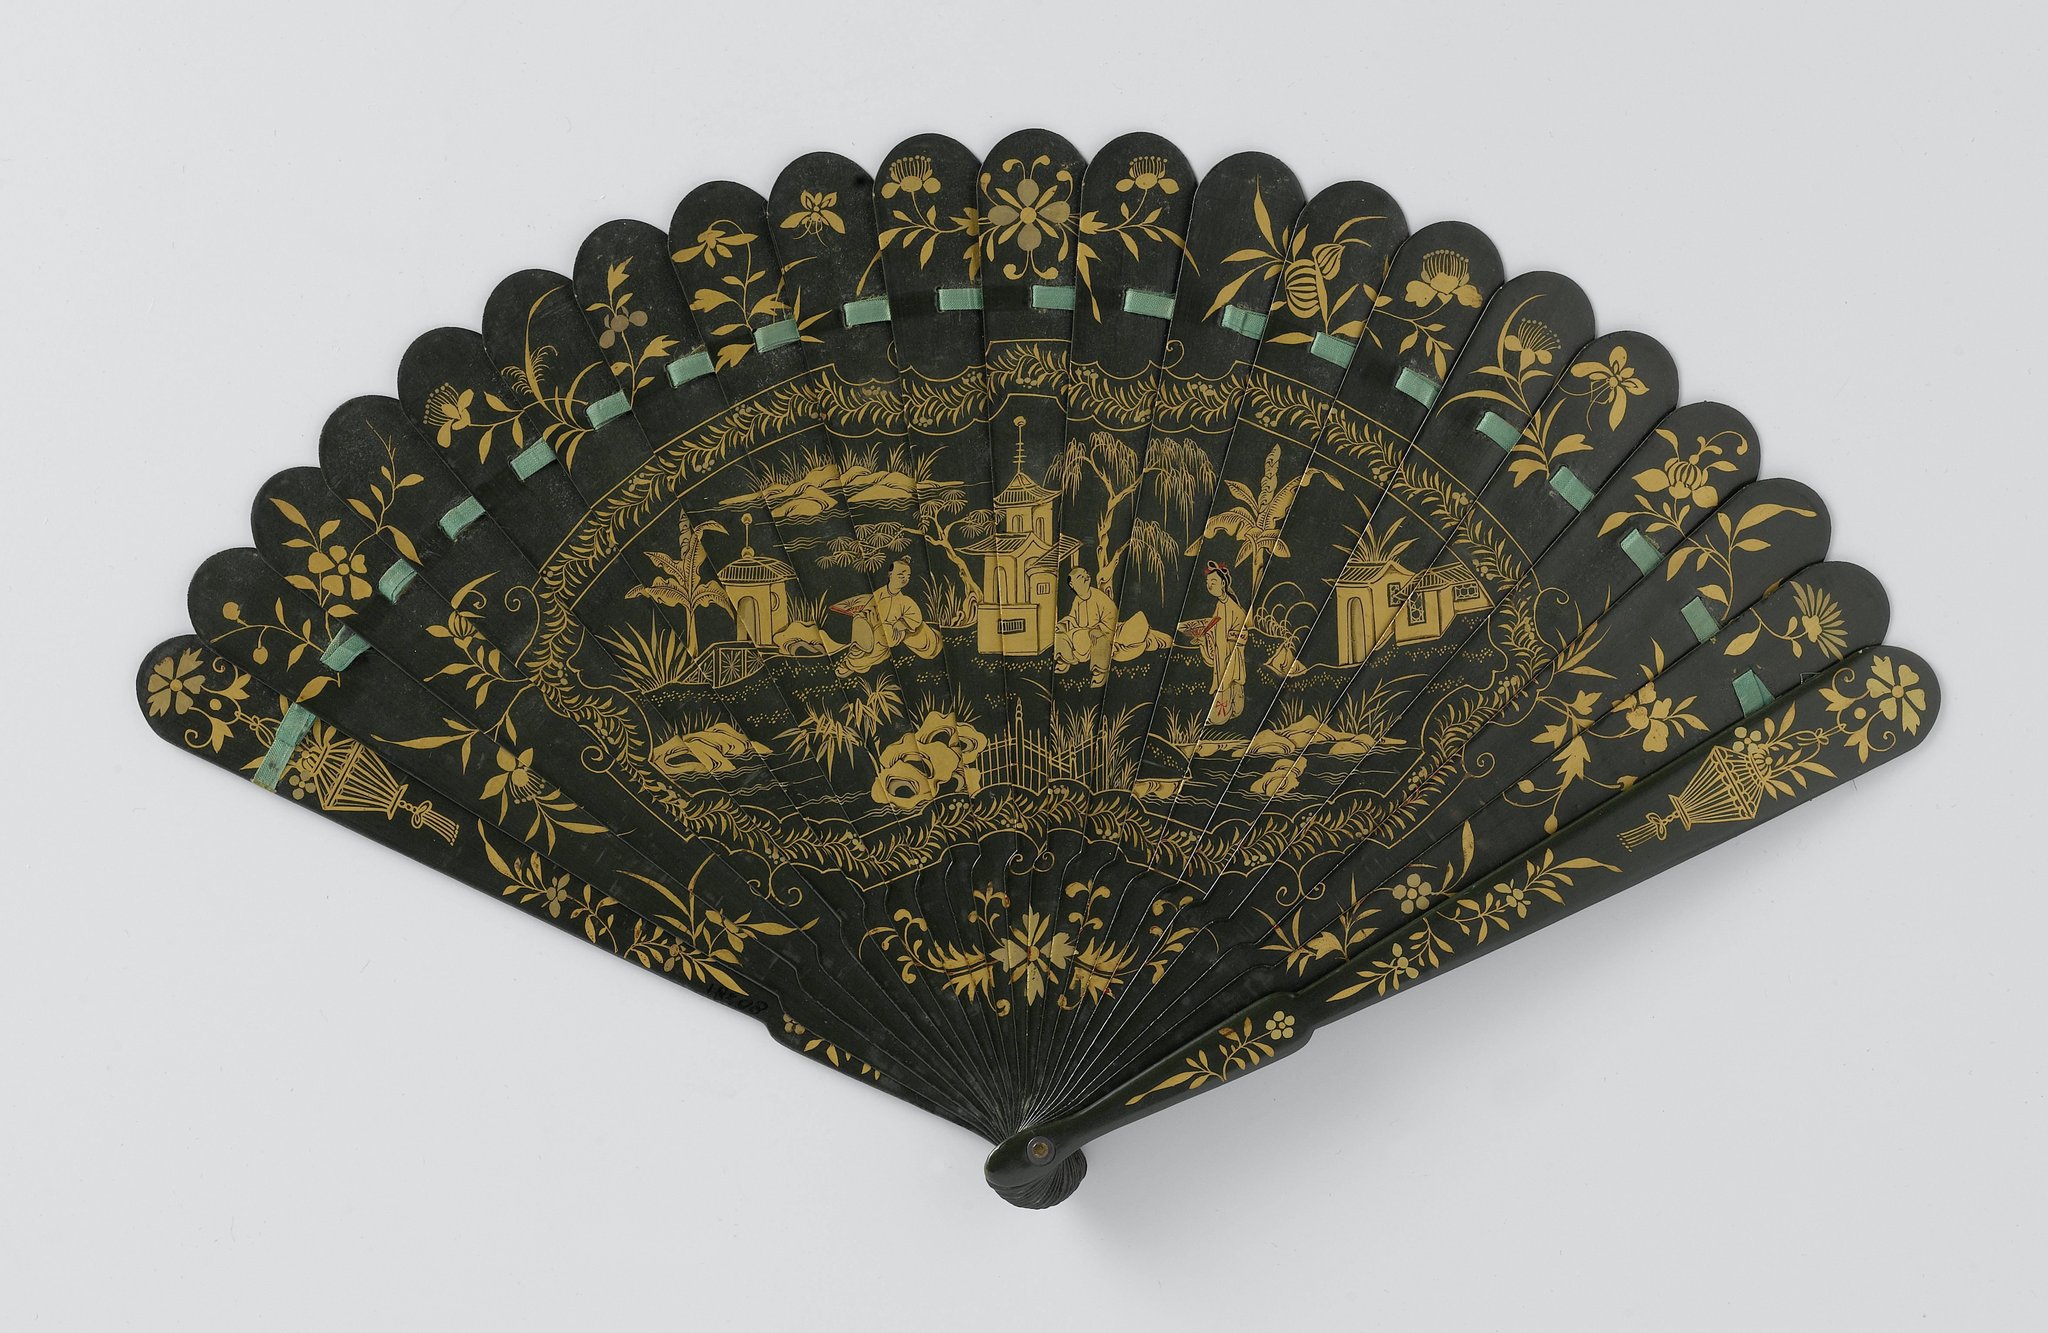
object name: brisé fan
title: Brisé-waaier met goudlak op fond van groene lak met een centrale cartouche waarin figuren in een landschap of tuin met paviljoens, waar omheen blad- en bloemmotieven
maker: Anonymous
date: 1880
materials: paint, lacquer, wood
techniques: cutting, lacquer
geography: china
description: Op de voorkant: binnen de centrale cartouche een landschap met treurwilg, bananenbomen, bamboe en prunus met uitwaaierende takken. Op de voorgrond water met rotsen. Van de drie figuren hebben één man en één vrouw een waaier in hun hand, de andere man (met snor) zit tussen hen in op een rots en lijkt de interactie tussen de anderen gade te slaan. De vrouw draagt een ingewikkelde haartooi en is op verschillende plekken aangezet met rode verf. Op de achterkant: binnen een vergelijkbaar landschap is rechts een ommuurd hutje zichtbaar met de vrouw kijkend over het lage muurtje. In het midden zit de man met snor op een krukje en kijkt naar de vrouw, terwijl links een man met een gevulde schaal al weglopend achterom kijkt. Ook nu weer een paar toetsen rood in de figuren. De randversiering van blad- en bloemmotieven is op de voor- en achterkant gelijk, evenals op de buitenbenen. Metalen sluitpin met metalen schijfje.